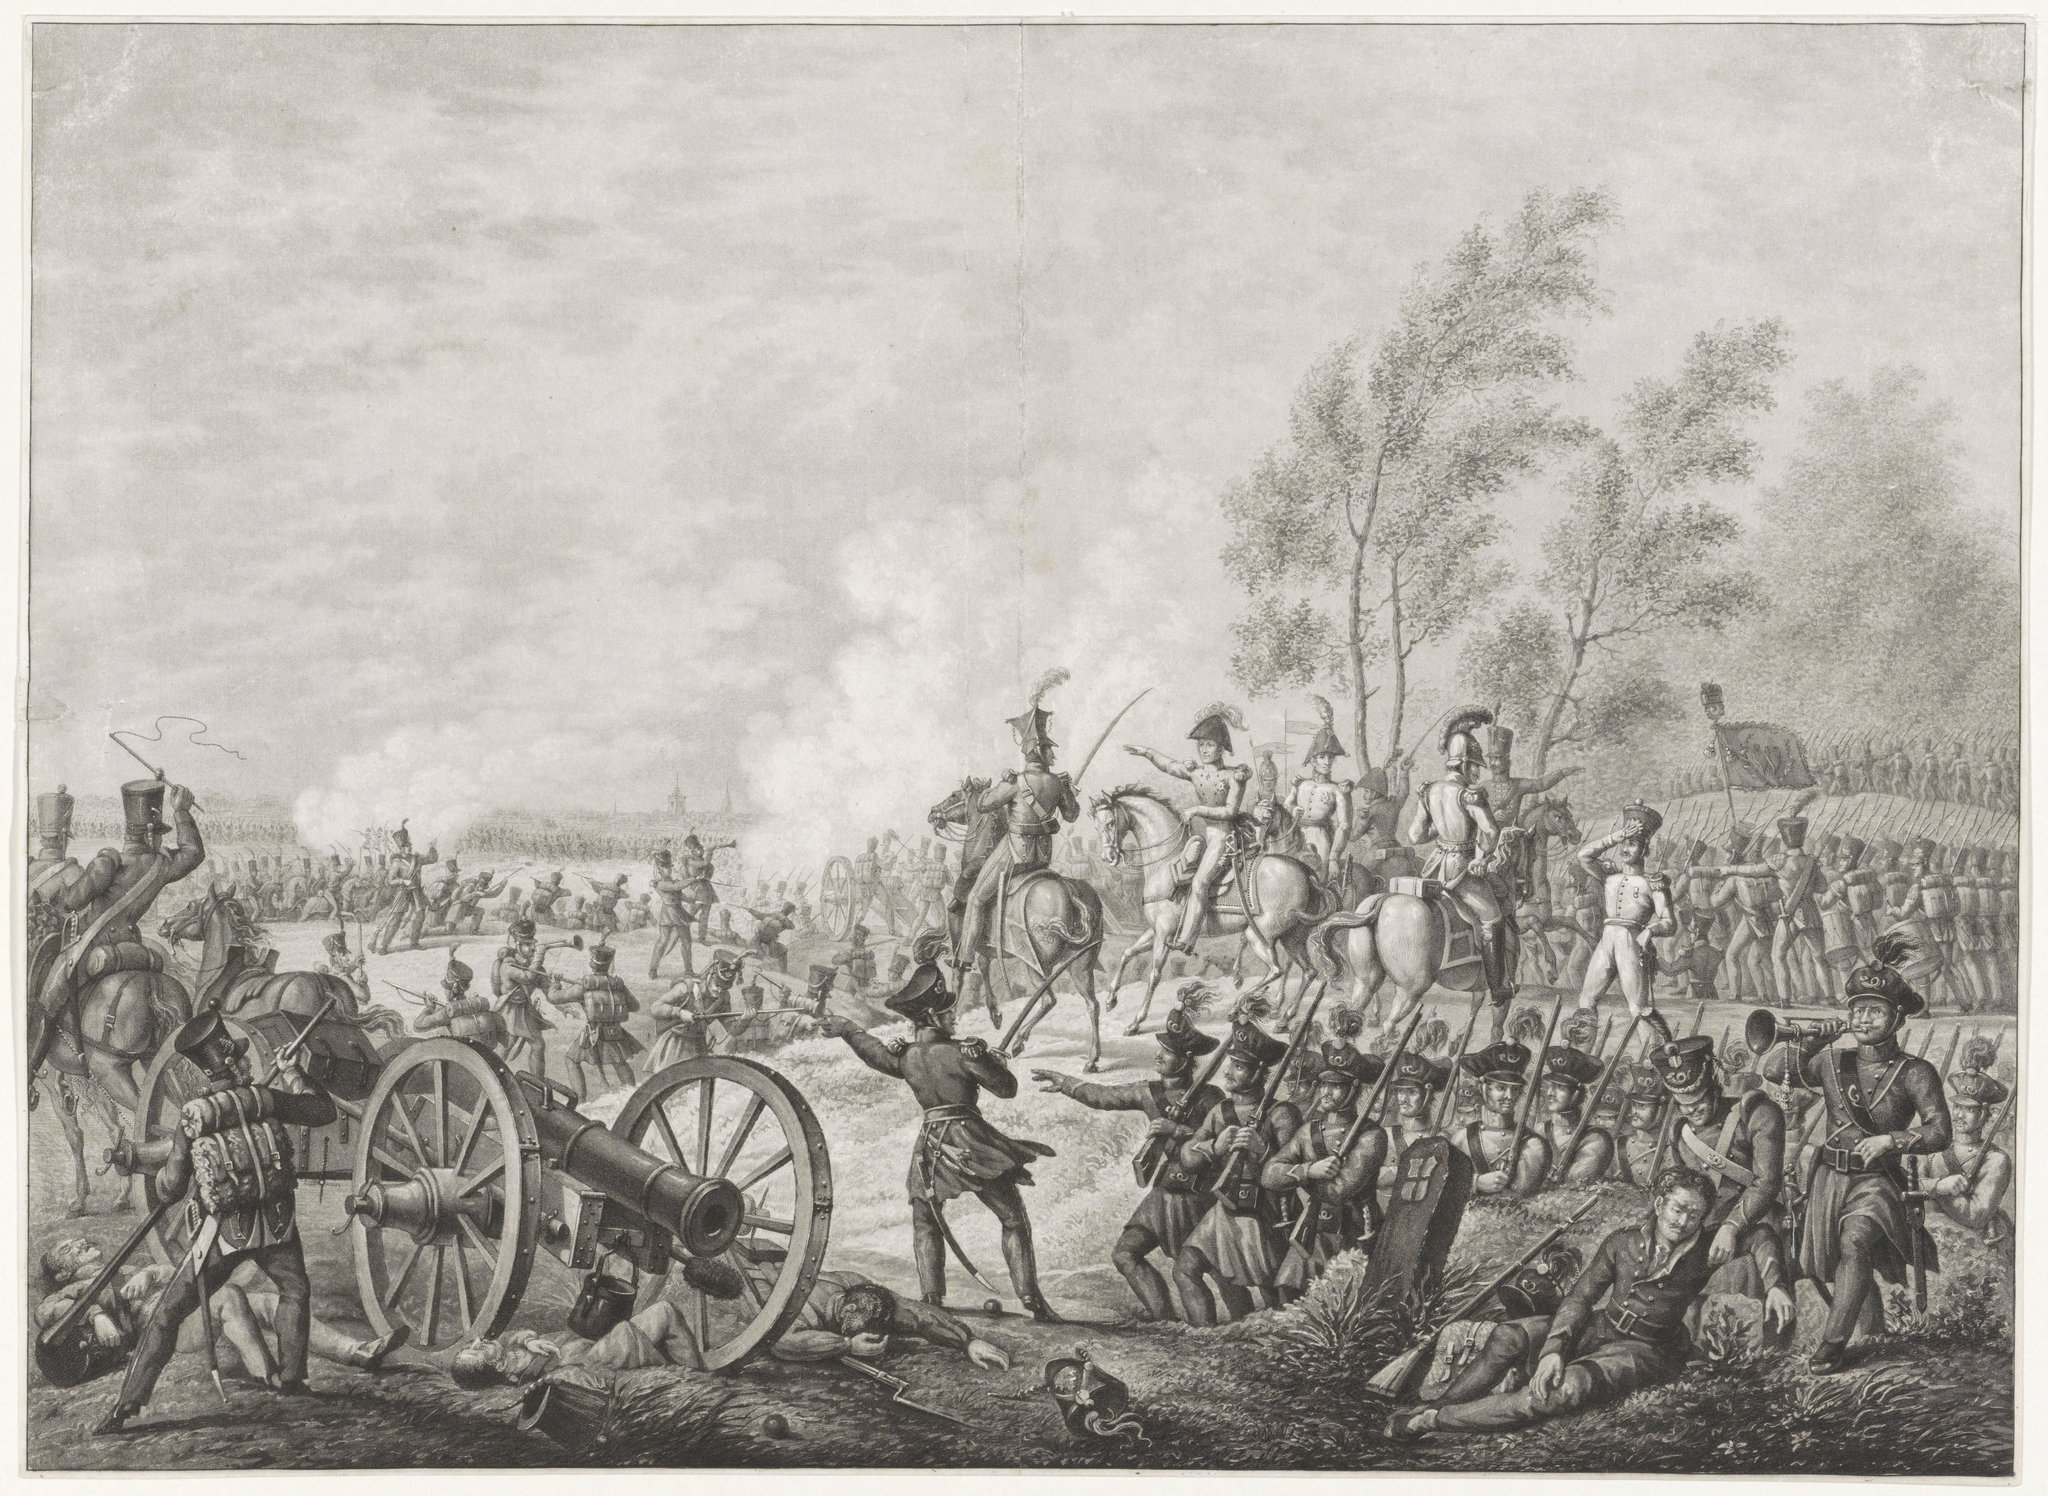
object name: print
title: Slag bij Hasselt, 1831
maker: willem hendrik hoogkamer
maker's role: draughtsman, print maker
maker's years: 1790-1864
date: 1831-1832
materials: paper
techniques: aquatint, etching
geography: netherlands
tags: william ii of the netherlands, berlin, frederik (prins der nederlanden), battle (+ land forces)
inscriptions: collector's mark: Lugt 2228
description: Overwinning van de Nederlandse troepen in de slag bij Hasselt op 8 augustus 1831. In het midden de prins van Oranje en prins Frederik te paard omringd door hun staf. Op de voorgrond een groep optrekkende vrijwillige jagers. In de verte de torens van de stad Hasselt. Zie ook de pendant. Bij de prent behoort een afzonderlijke verklaring.